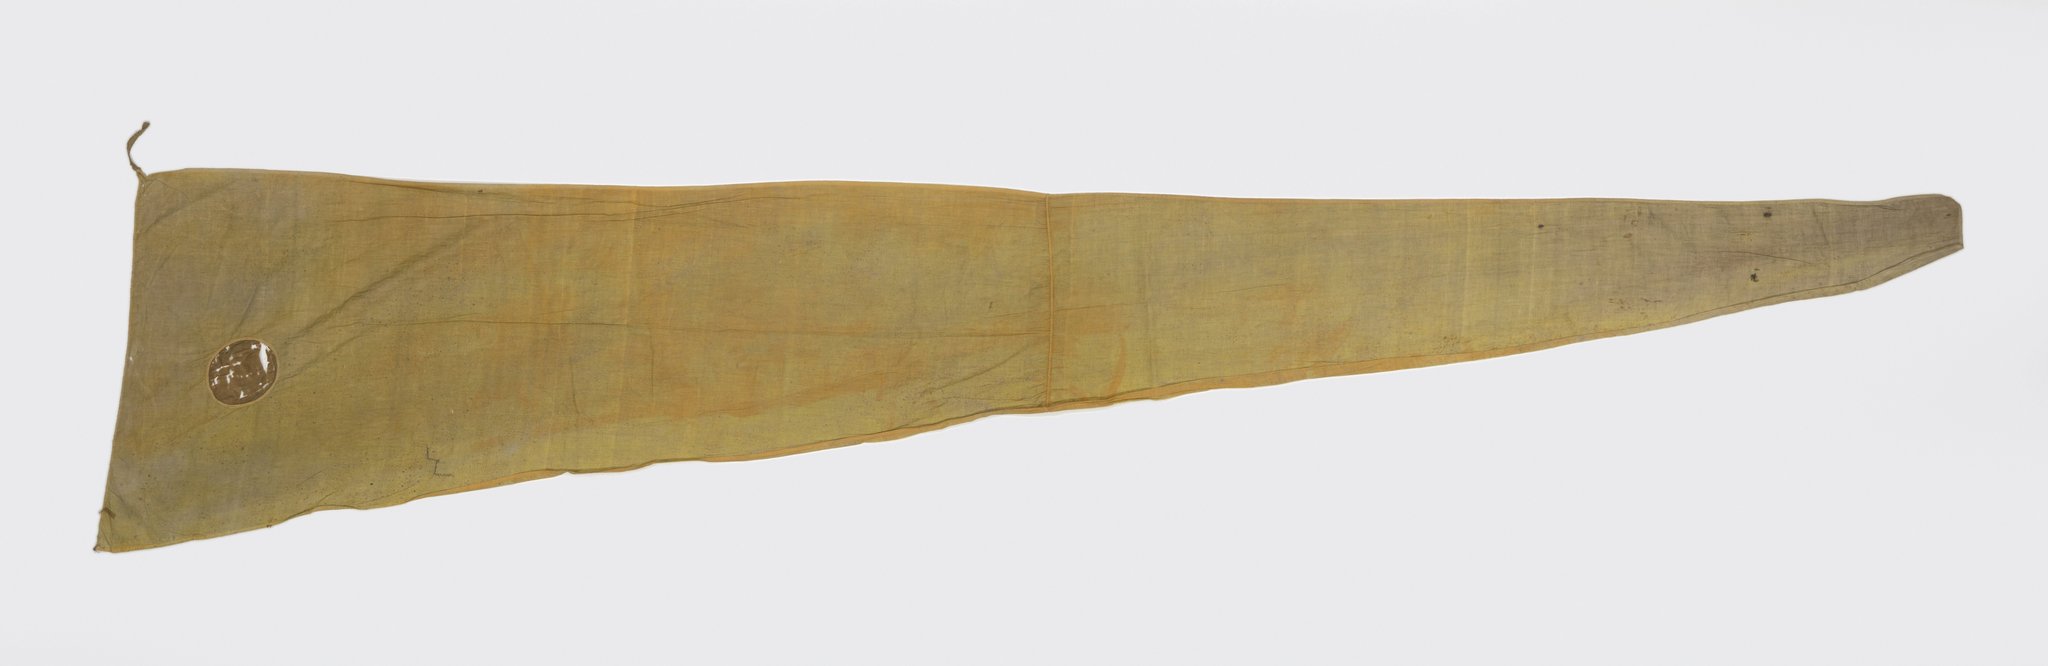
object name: flag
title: Pennant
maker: Anonymous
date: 1750-1830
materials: cotton, linen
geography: indonesian archipelago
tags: flag, colours (as symbol of the state, etc.), dutch east indies, the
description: Lange gele wimpel, rechthoekige driehoek met afgeknotte punt, met een (oorspronkelijk blauwe) cirkel bij de broek.